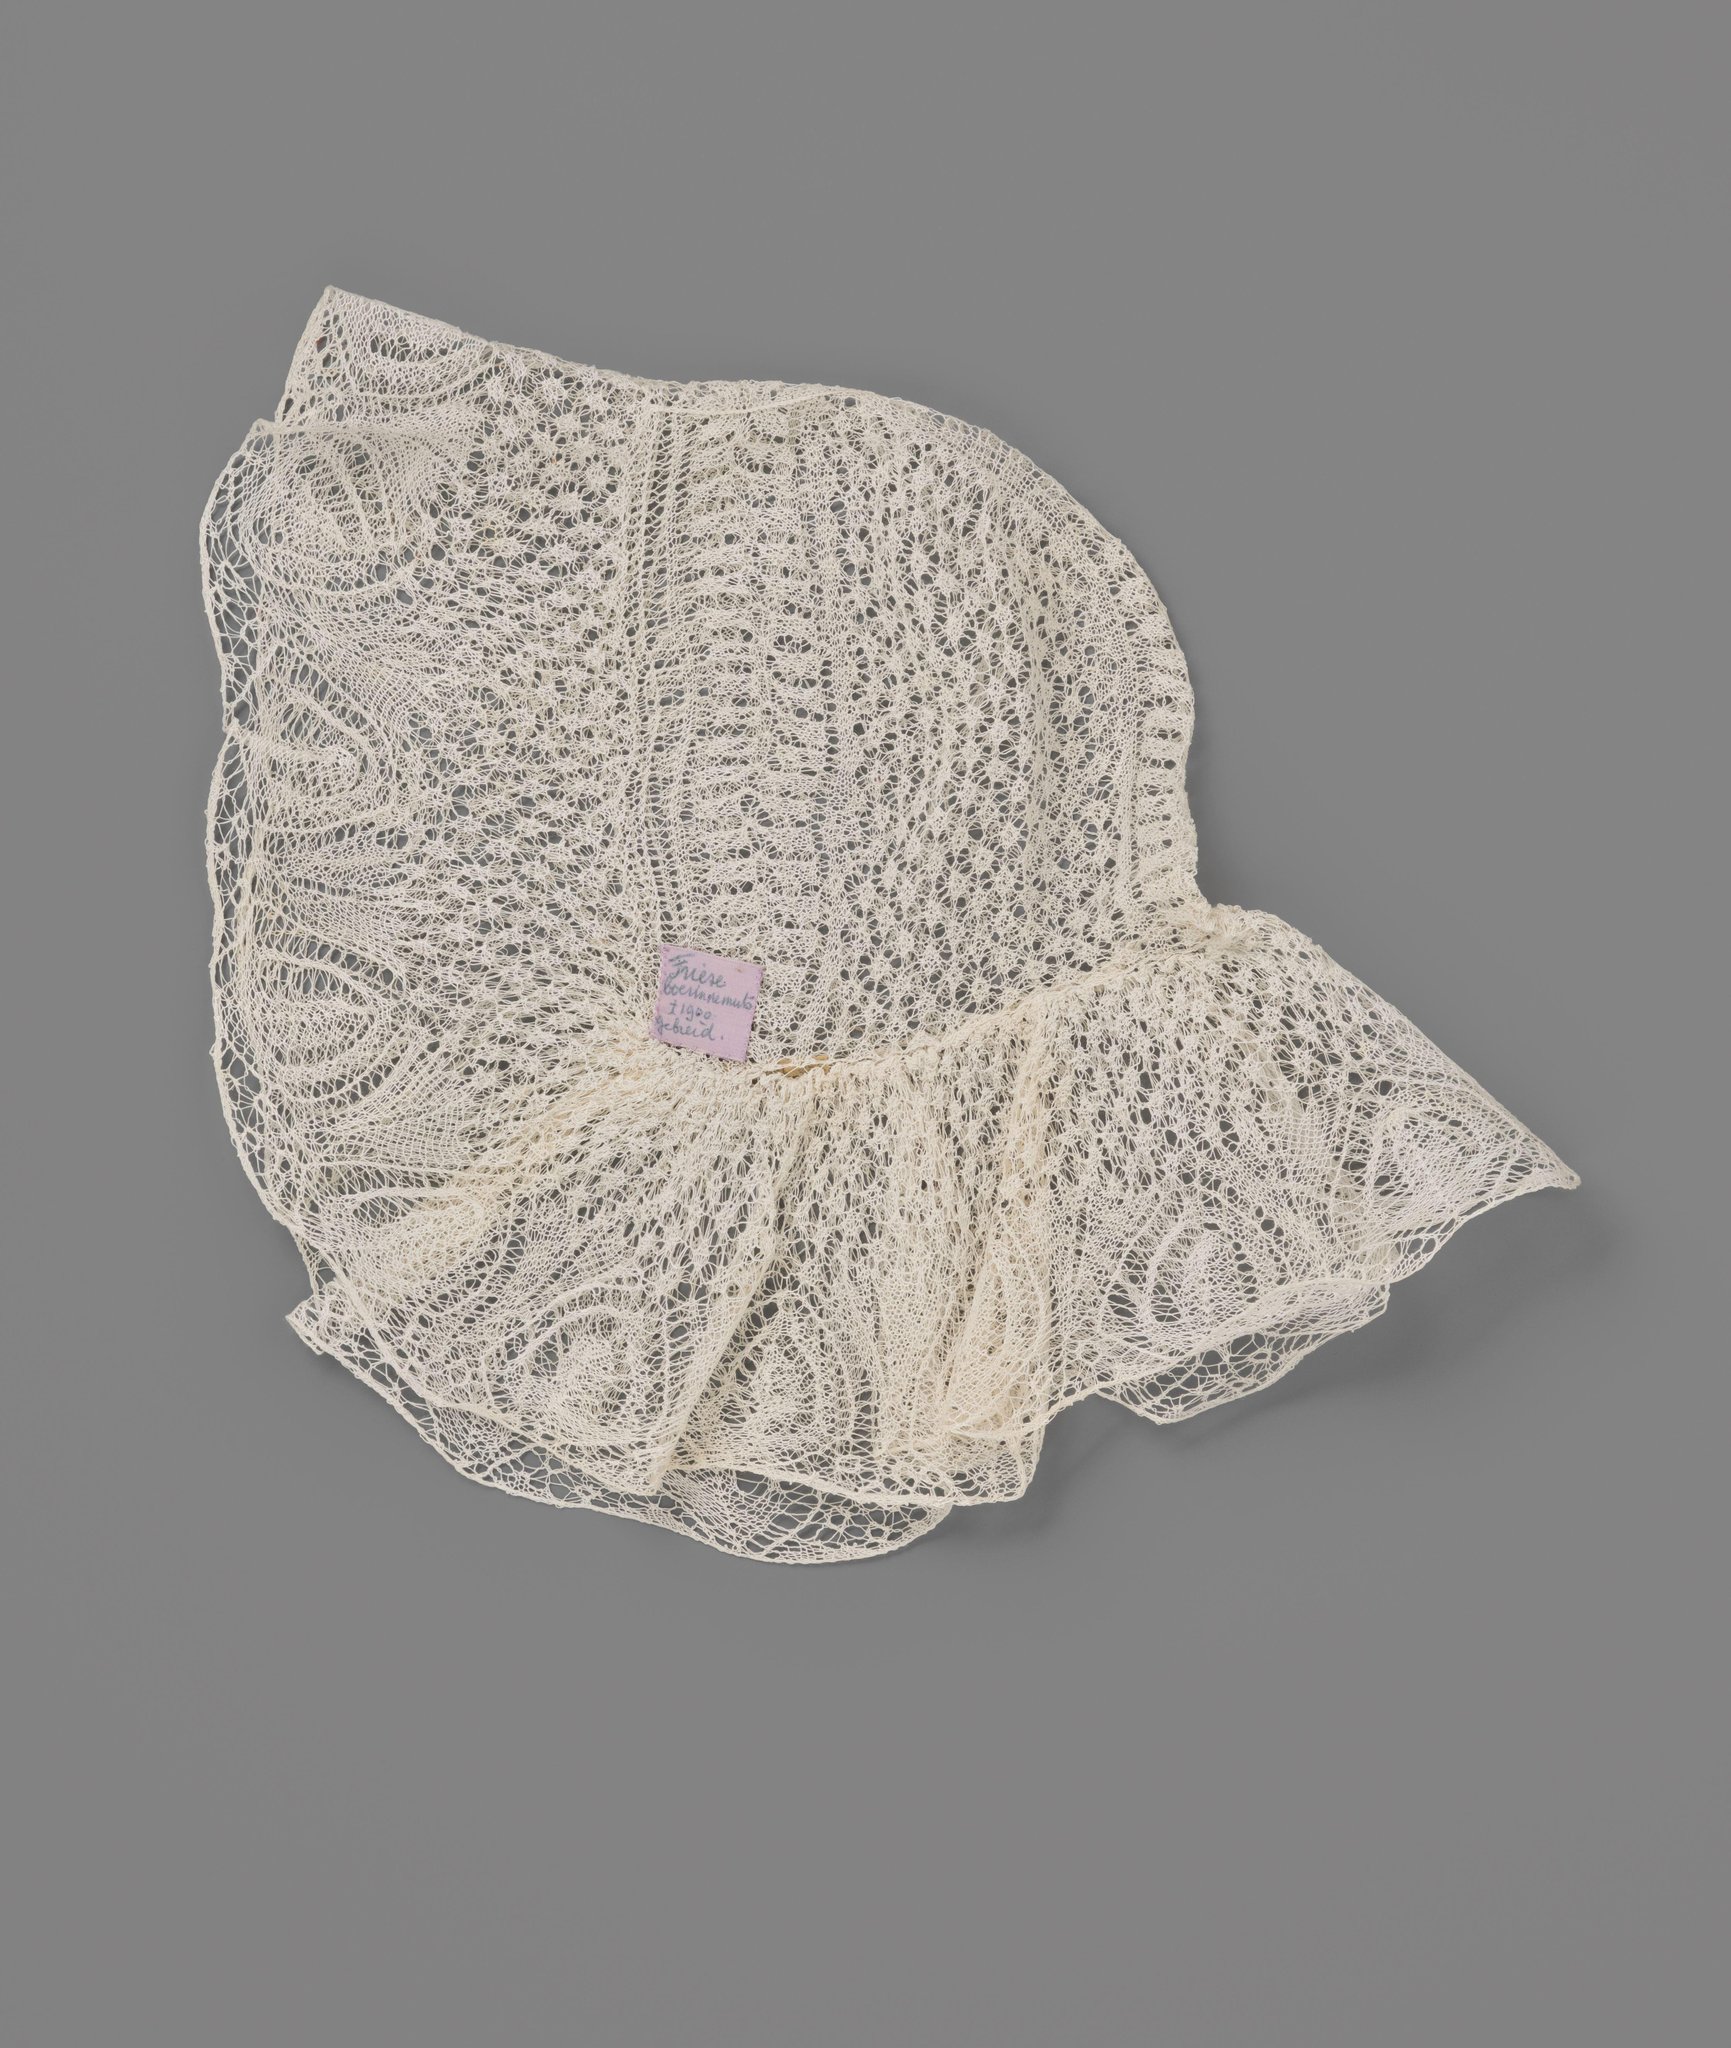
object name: cap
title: Muts van gebreide kant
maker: Anonymous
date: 1900-2000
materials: lace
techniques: cockled, knitting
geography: friesland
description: Muts van gebreide kant, opgebouwd uit een bol waaraan een aangerimpelde luifelstrook.